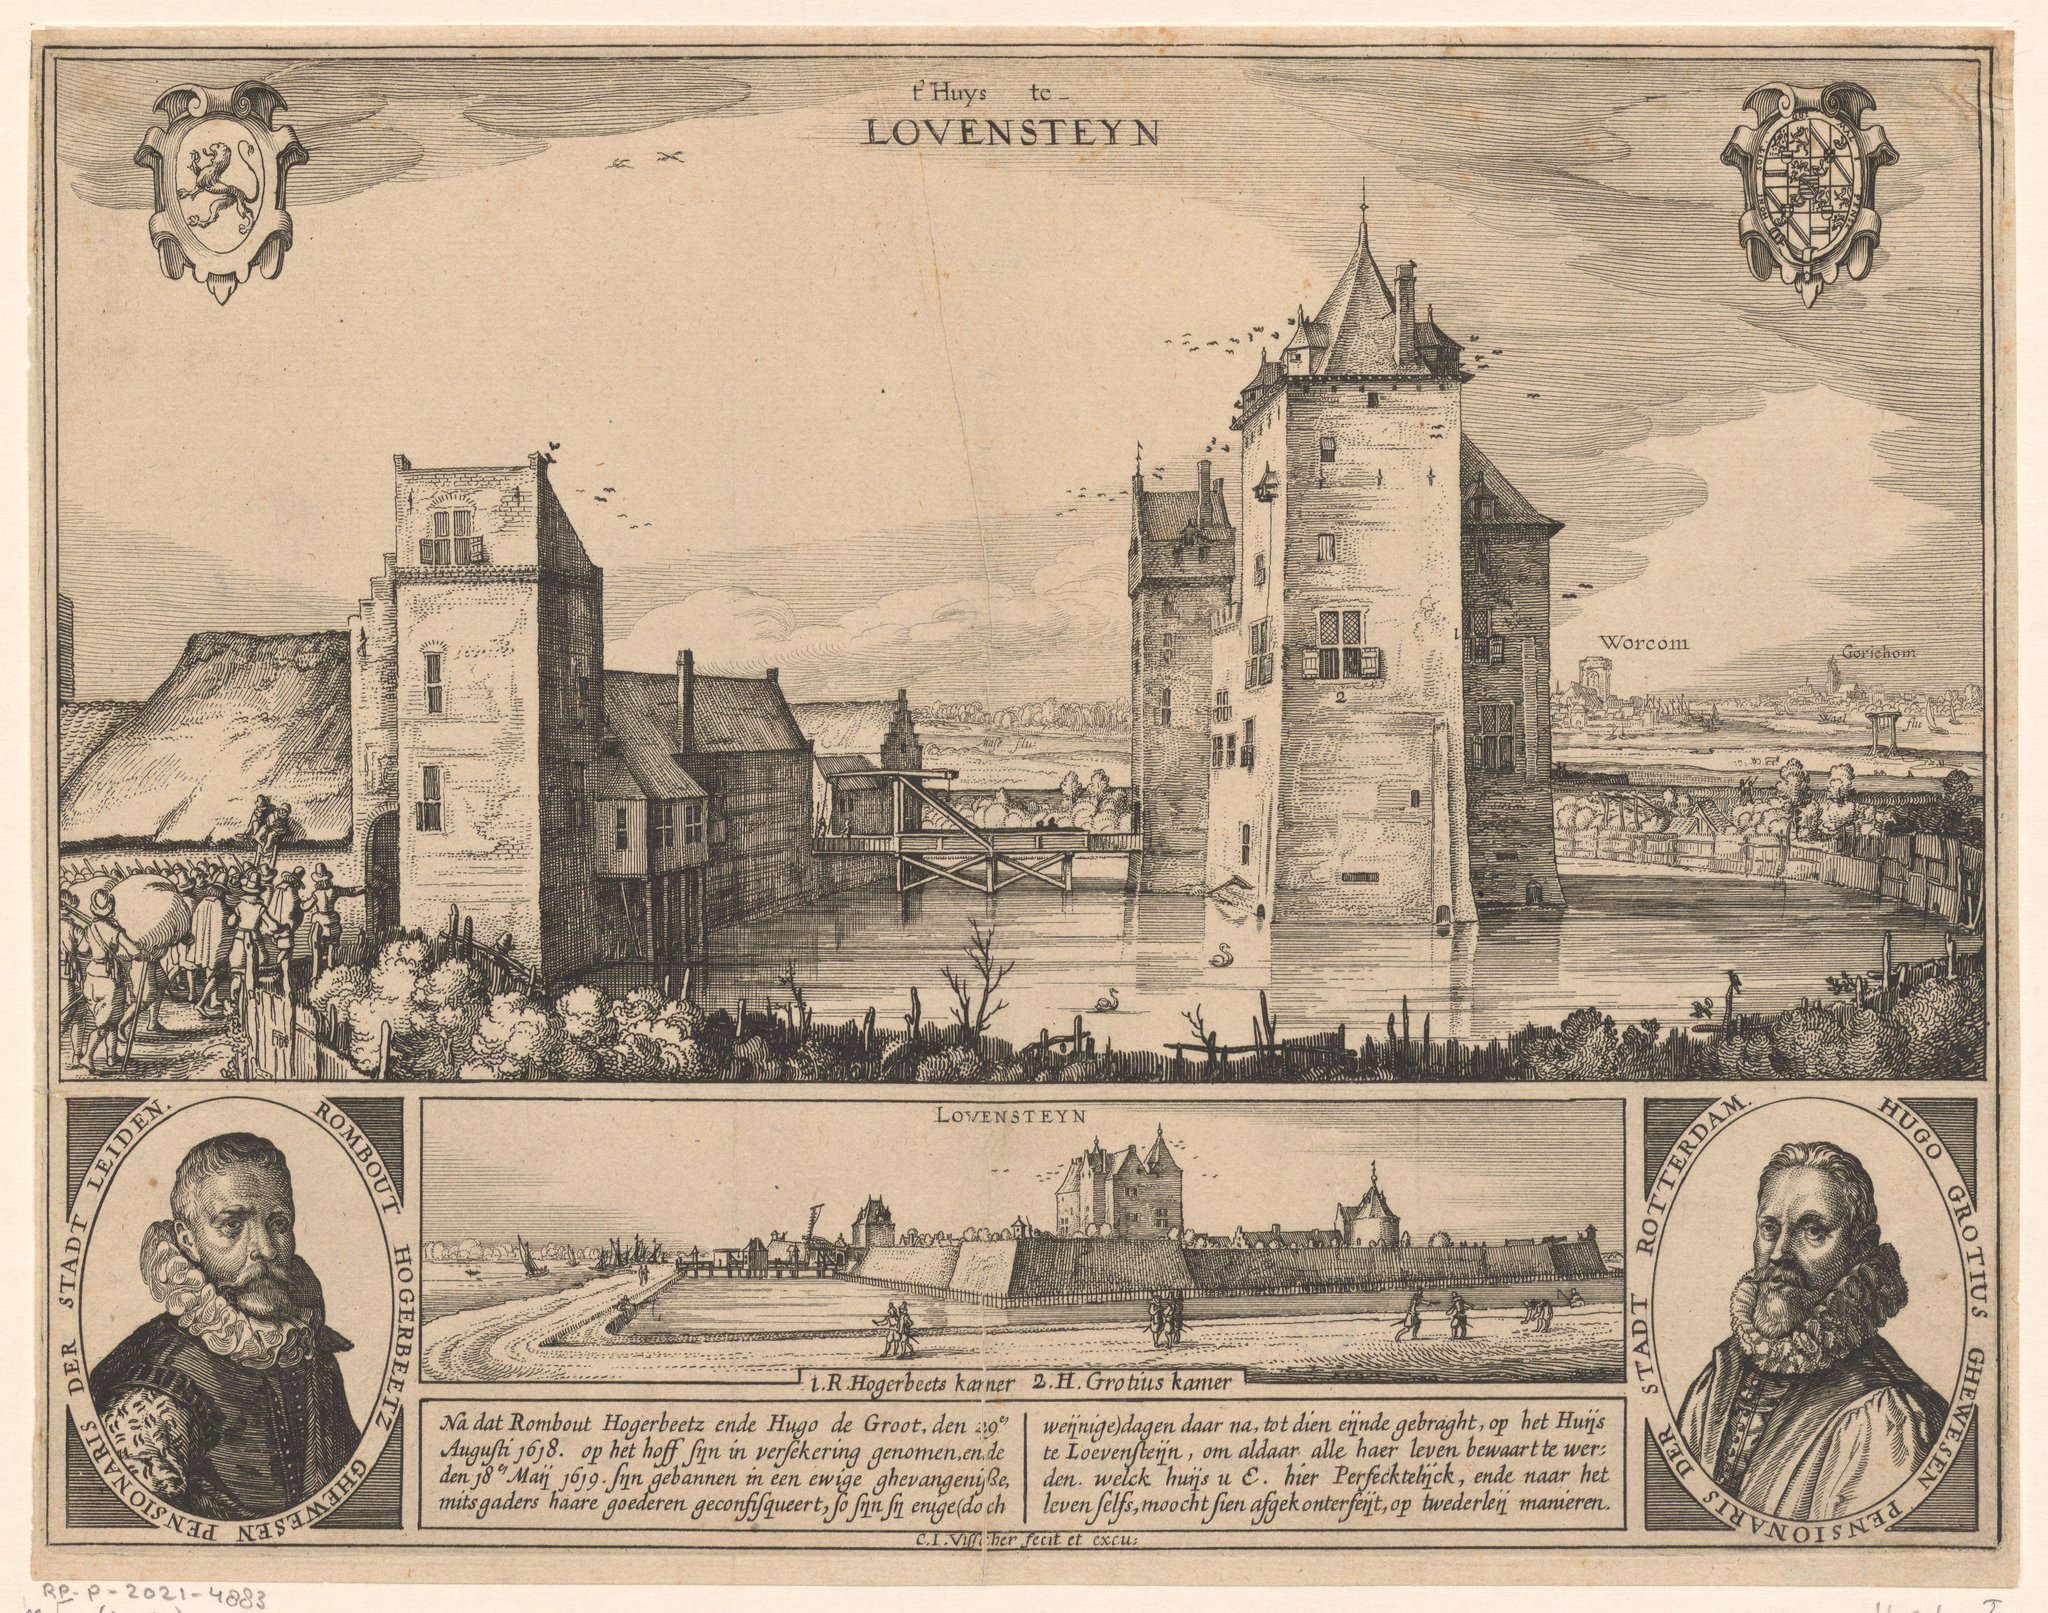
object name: print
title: Slot Loevestein waar Rombout Hogerbeets en Hugo de Groot gevangen zaten, 1619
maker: claes jansz. visscher (ii)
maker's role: draughtsman, print maker, publisher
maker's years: 1586-1652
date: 1619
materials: paper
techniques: engraving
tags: delft, hugo de groot, hoorn (north holland), petrus hogerbeets, castle, historical persons, imprisonment, armorial bearing, heraldry, loevestein castle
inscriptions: collector's mark: Lugt 964, collector's mark: Lugt 2228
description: Gezicht op Slot Loevestein. Rombout Hogerbeets en Hugo de Groot waren beiden op 18 mei 1619 tot levenslange opsluiting in het kasteel veroordeeld. Linksboven het wapen van Holland, rechtsboven dat van Maurits van Oranje. Links de aankomst van de gevangenen begeleid door soldaten. In de verte de steden Woudrichem en Gorinchem. Onderaan twee portretten van de veroordeelden en een tweede gezicht op Loevestein met een korte beschrijving van gebeurtenis.